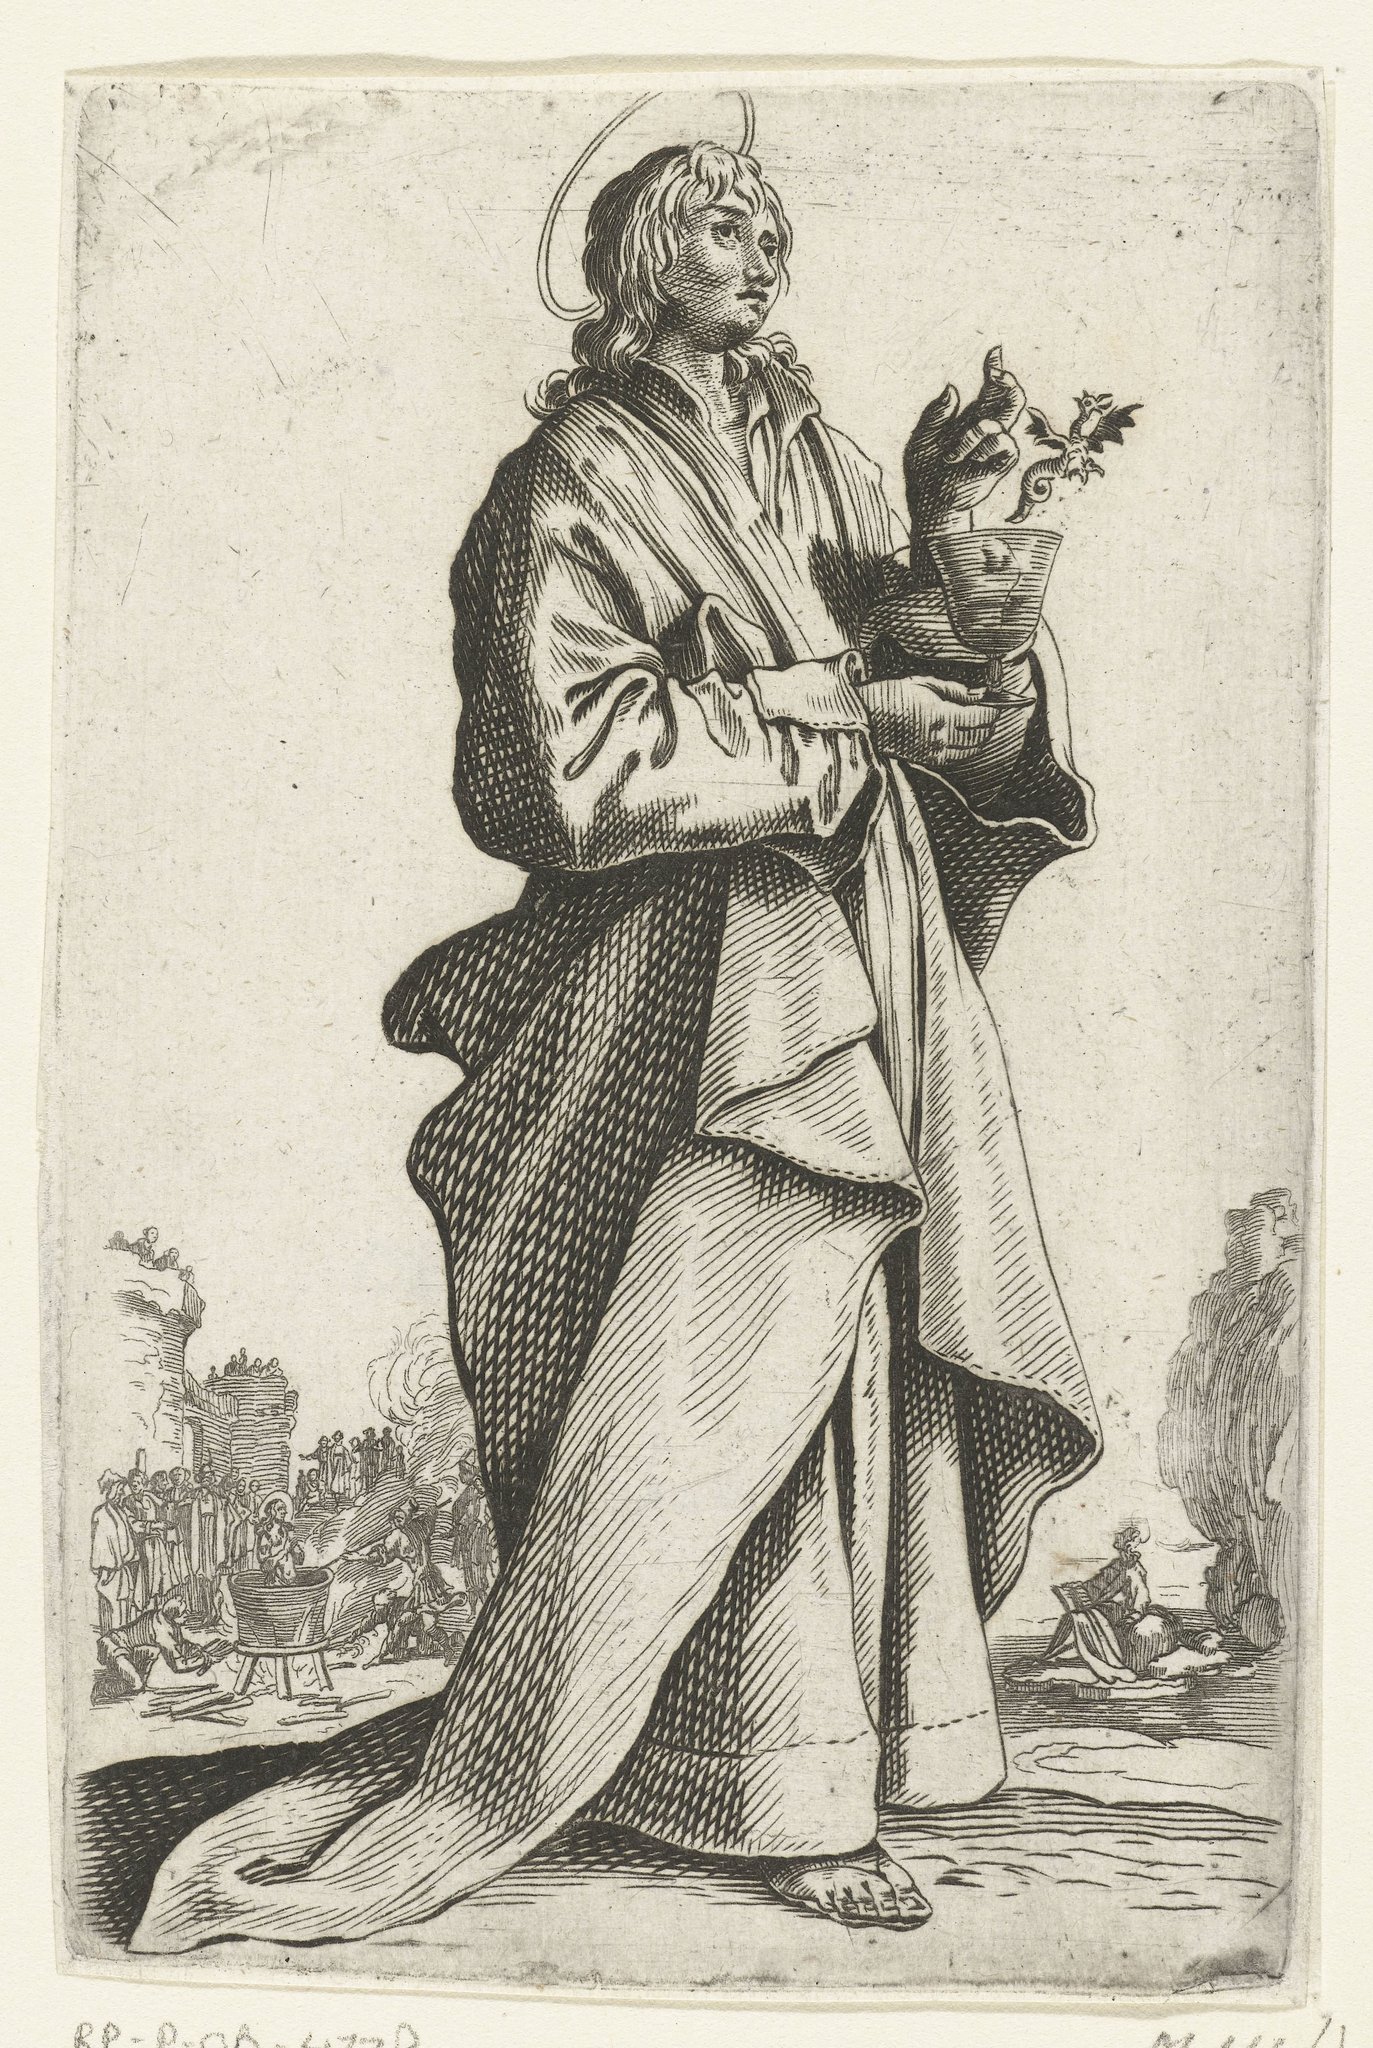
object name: print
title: Christus, Maria en de apostelen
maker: Anonymous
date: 1631-1699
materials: paper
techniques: engraving, etching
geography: france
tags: the apostle john the evangelist; possible attributes: book, cauldron, chalice with snake, eagle, palm, scroll, john (writing) on the island of patmos, possibly the eagle beside him, martyrdom of john in front of the porta latina: he is put in a cauldron of boiling oil, but remains unharmed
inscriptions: collector's mark: Lugt 240